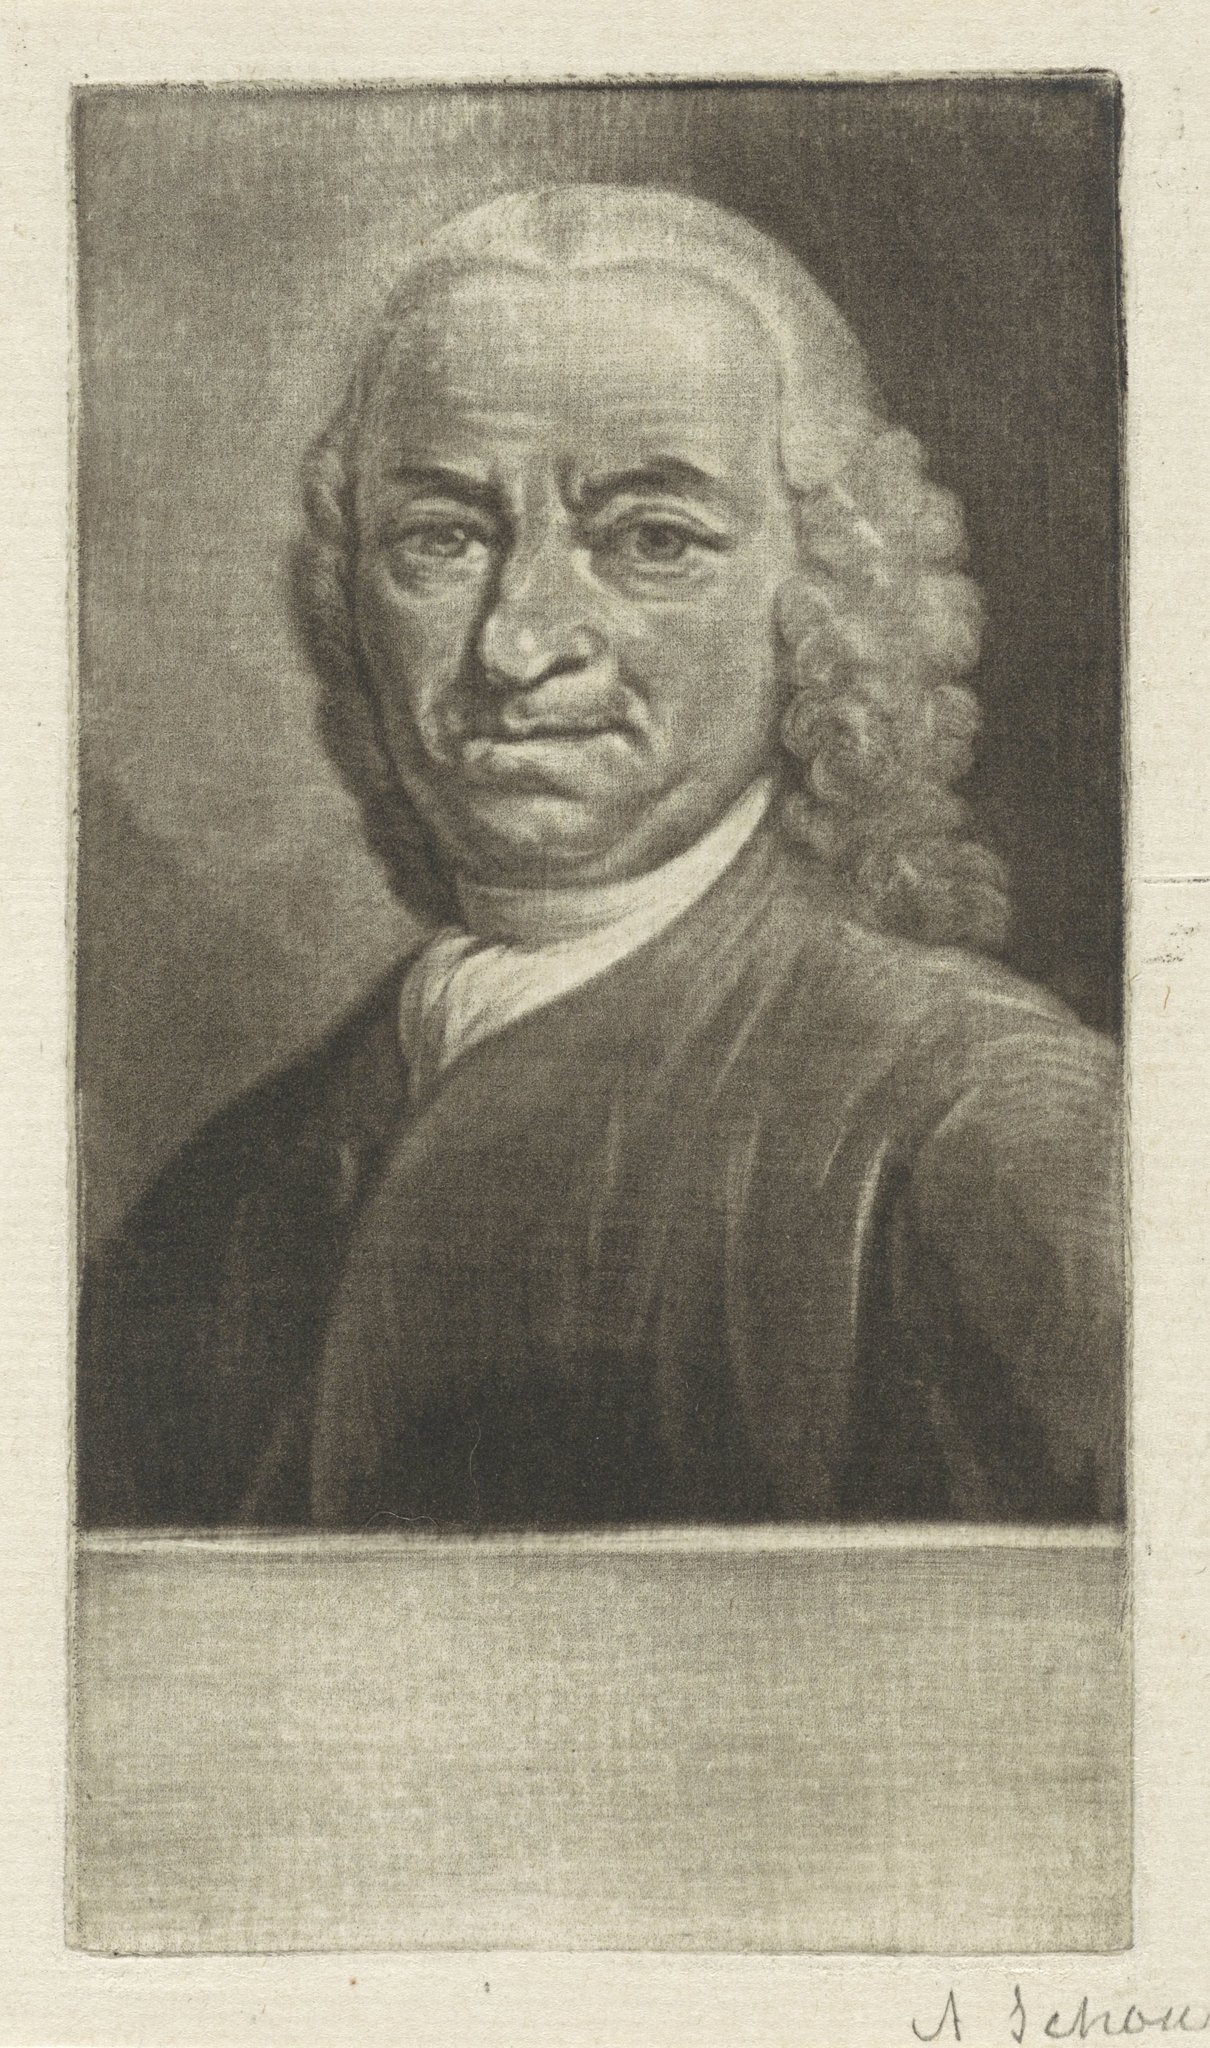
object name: print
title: Portret van en man, mogelijk Gerrit Kuipers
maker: aert schouman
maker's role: draughtsman, painter, print maker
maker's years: 1710-1792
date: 1750-1792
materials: paper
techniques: mezzotint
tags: physicist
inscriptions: collector's mark: Lugt 2228